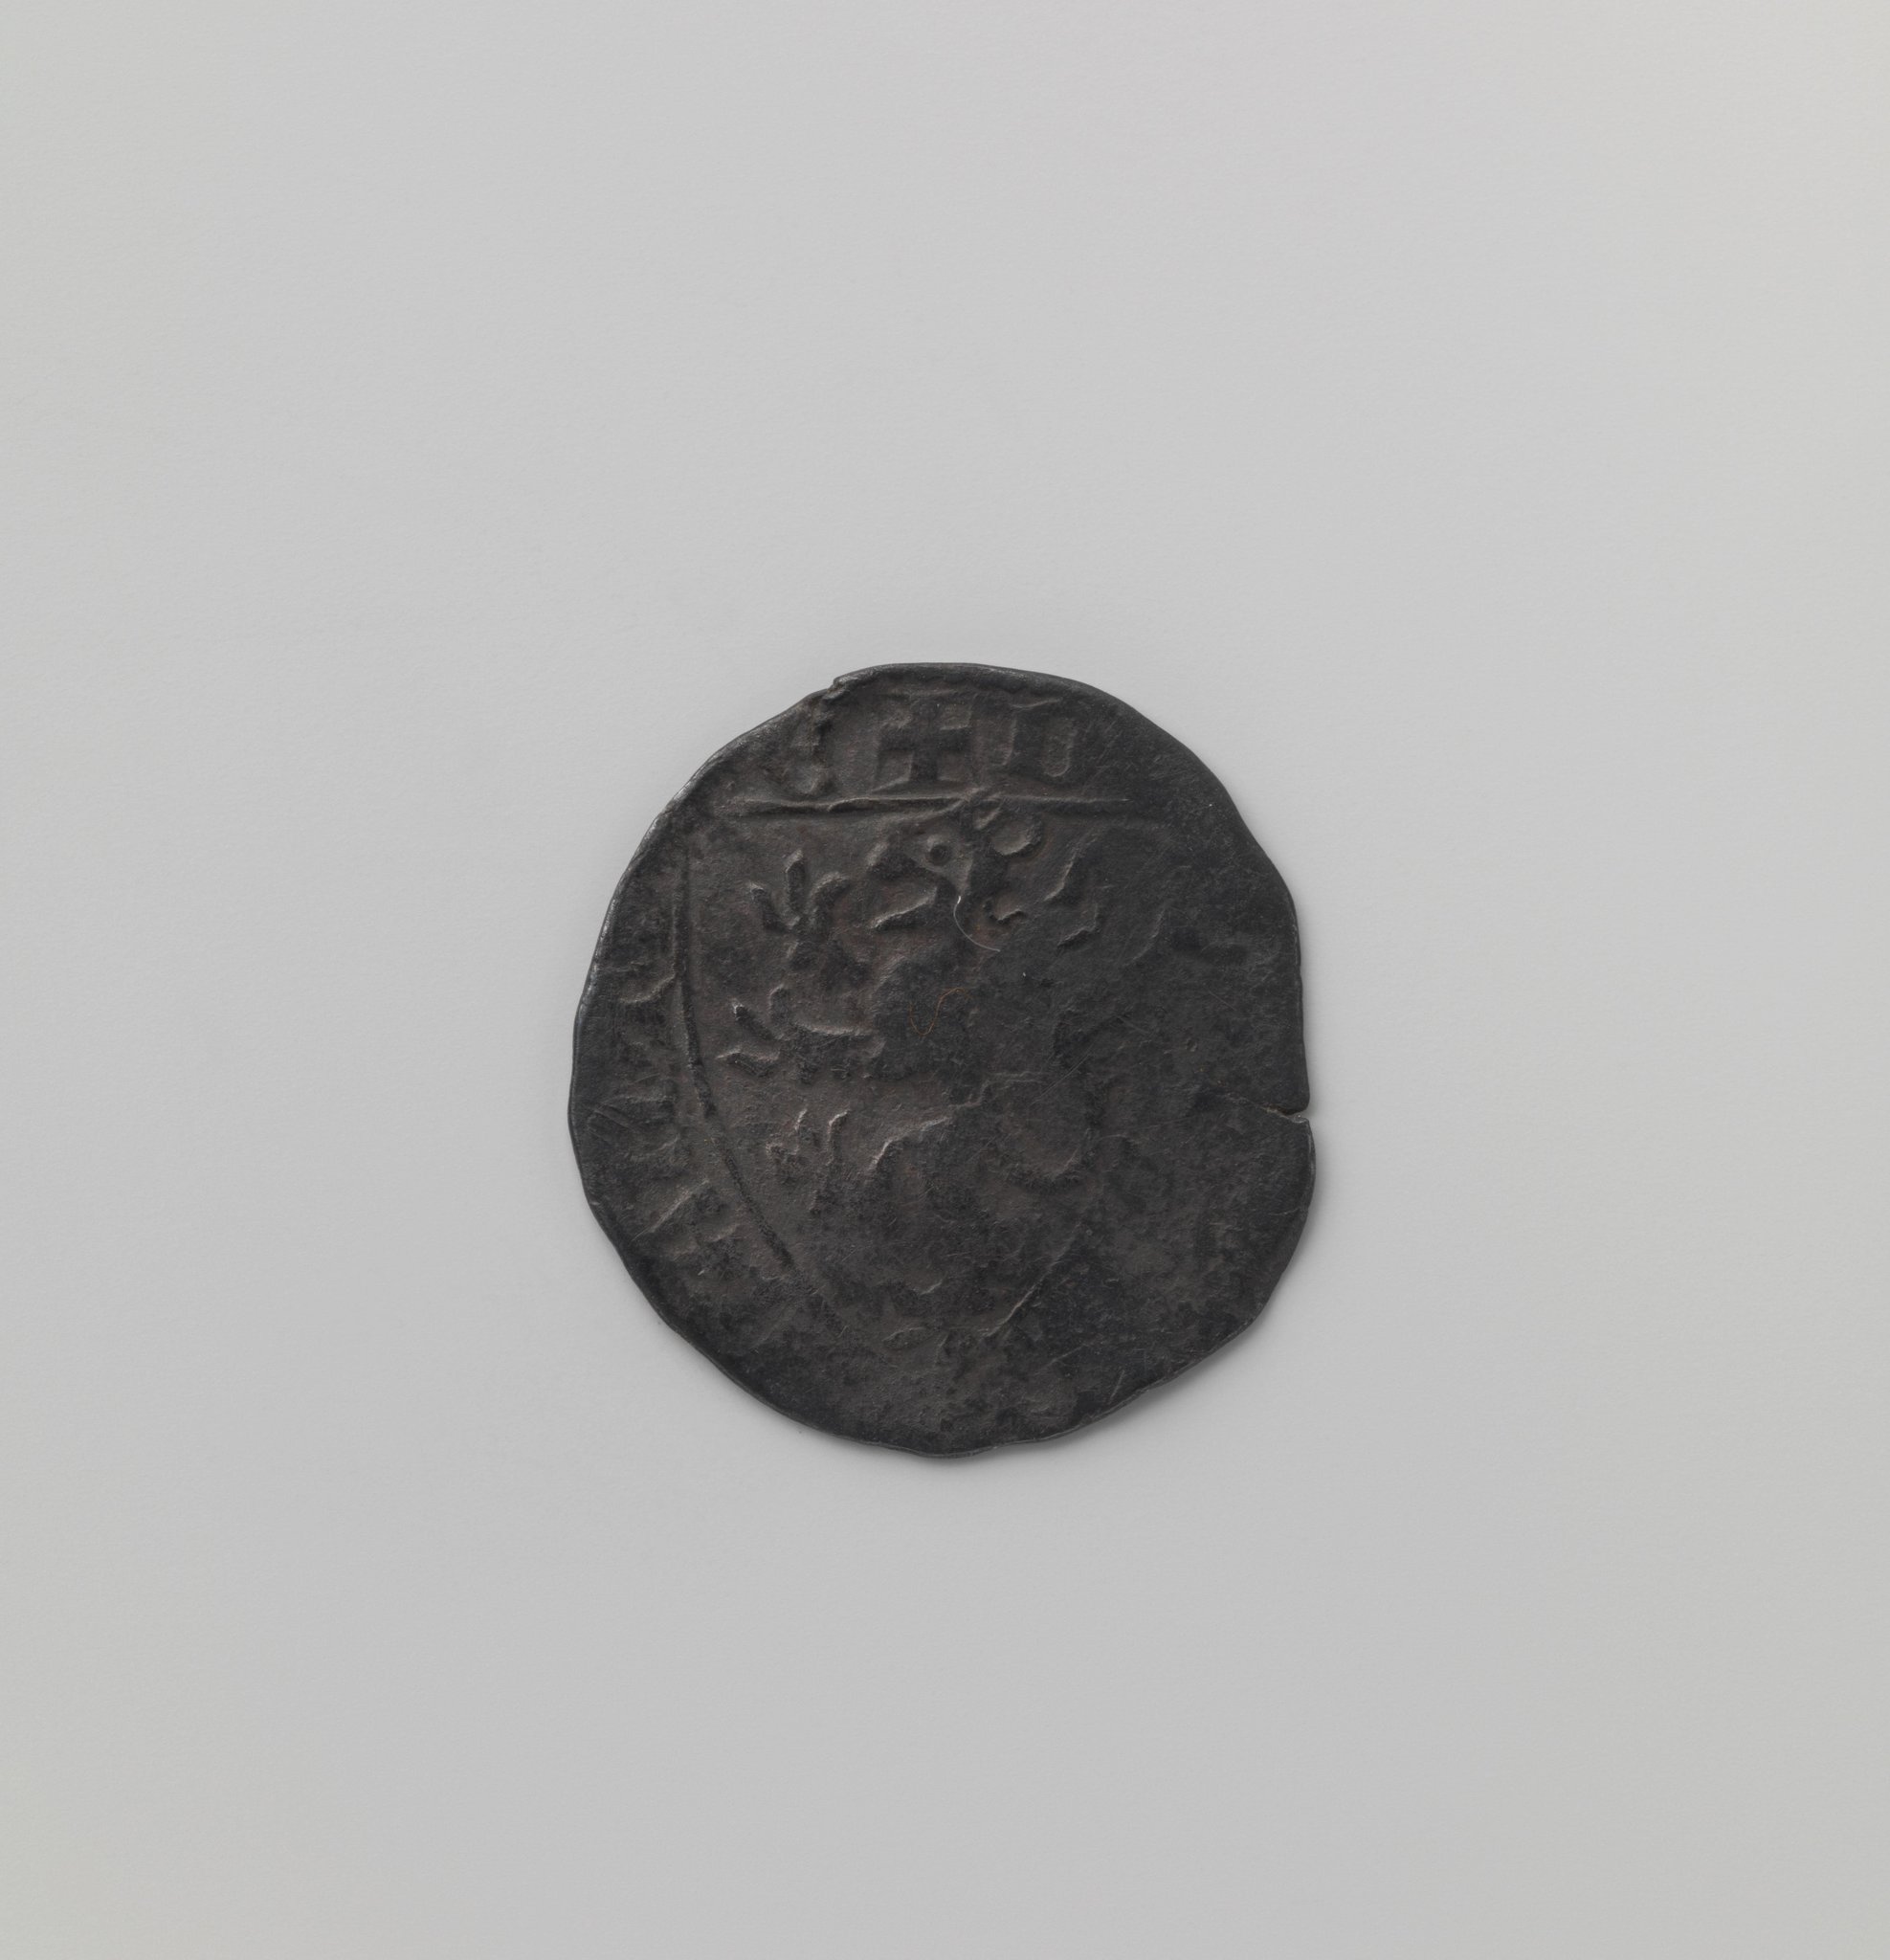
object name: coin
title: Brabant, Jan I, sterling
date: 1268-1294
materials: silver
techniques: striking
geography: brussels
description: Voorzijde: in een punt uitlopend wapenschild met leeuw, waaromheen omschrift. Keerzijde: lang dubbellijnig kruis, in de hoeken letters B,R,V en X. Daaromheen omschrift.